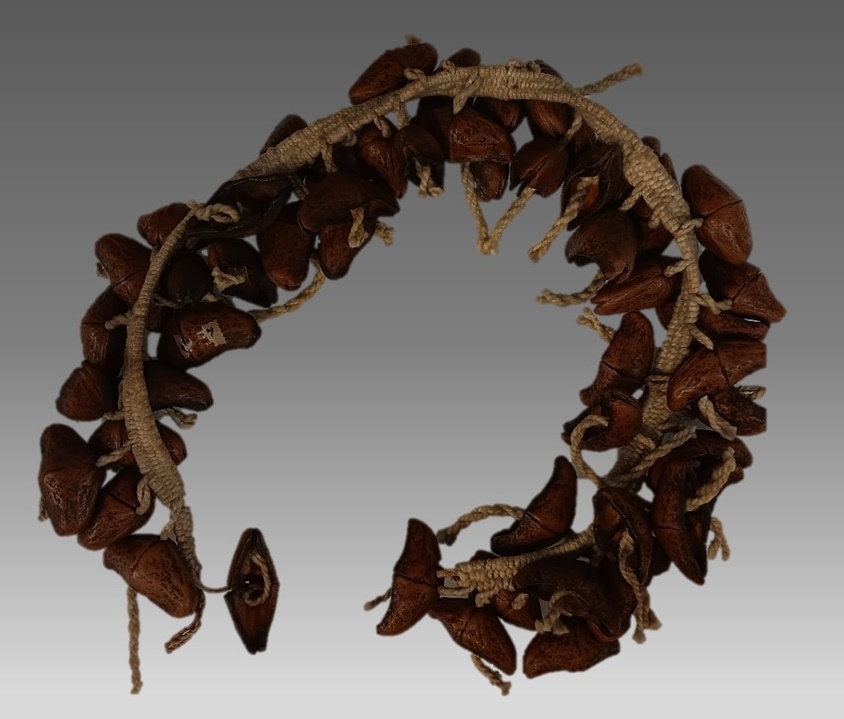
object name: strung rattle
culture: native american or guyanese or demerara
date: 1867-1900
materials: cord, cotton, shell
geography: guyana